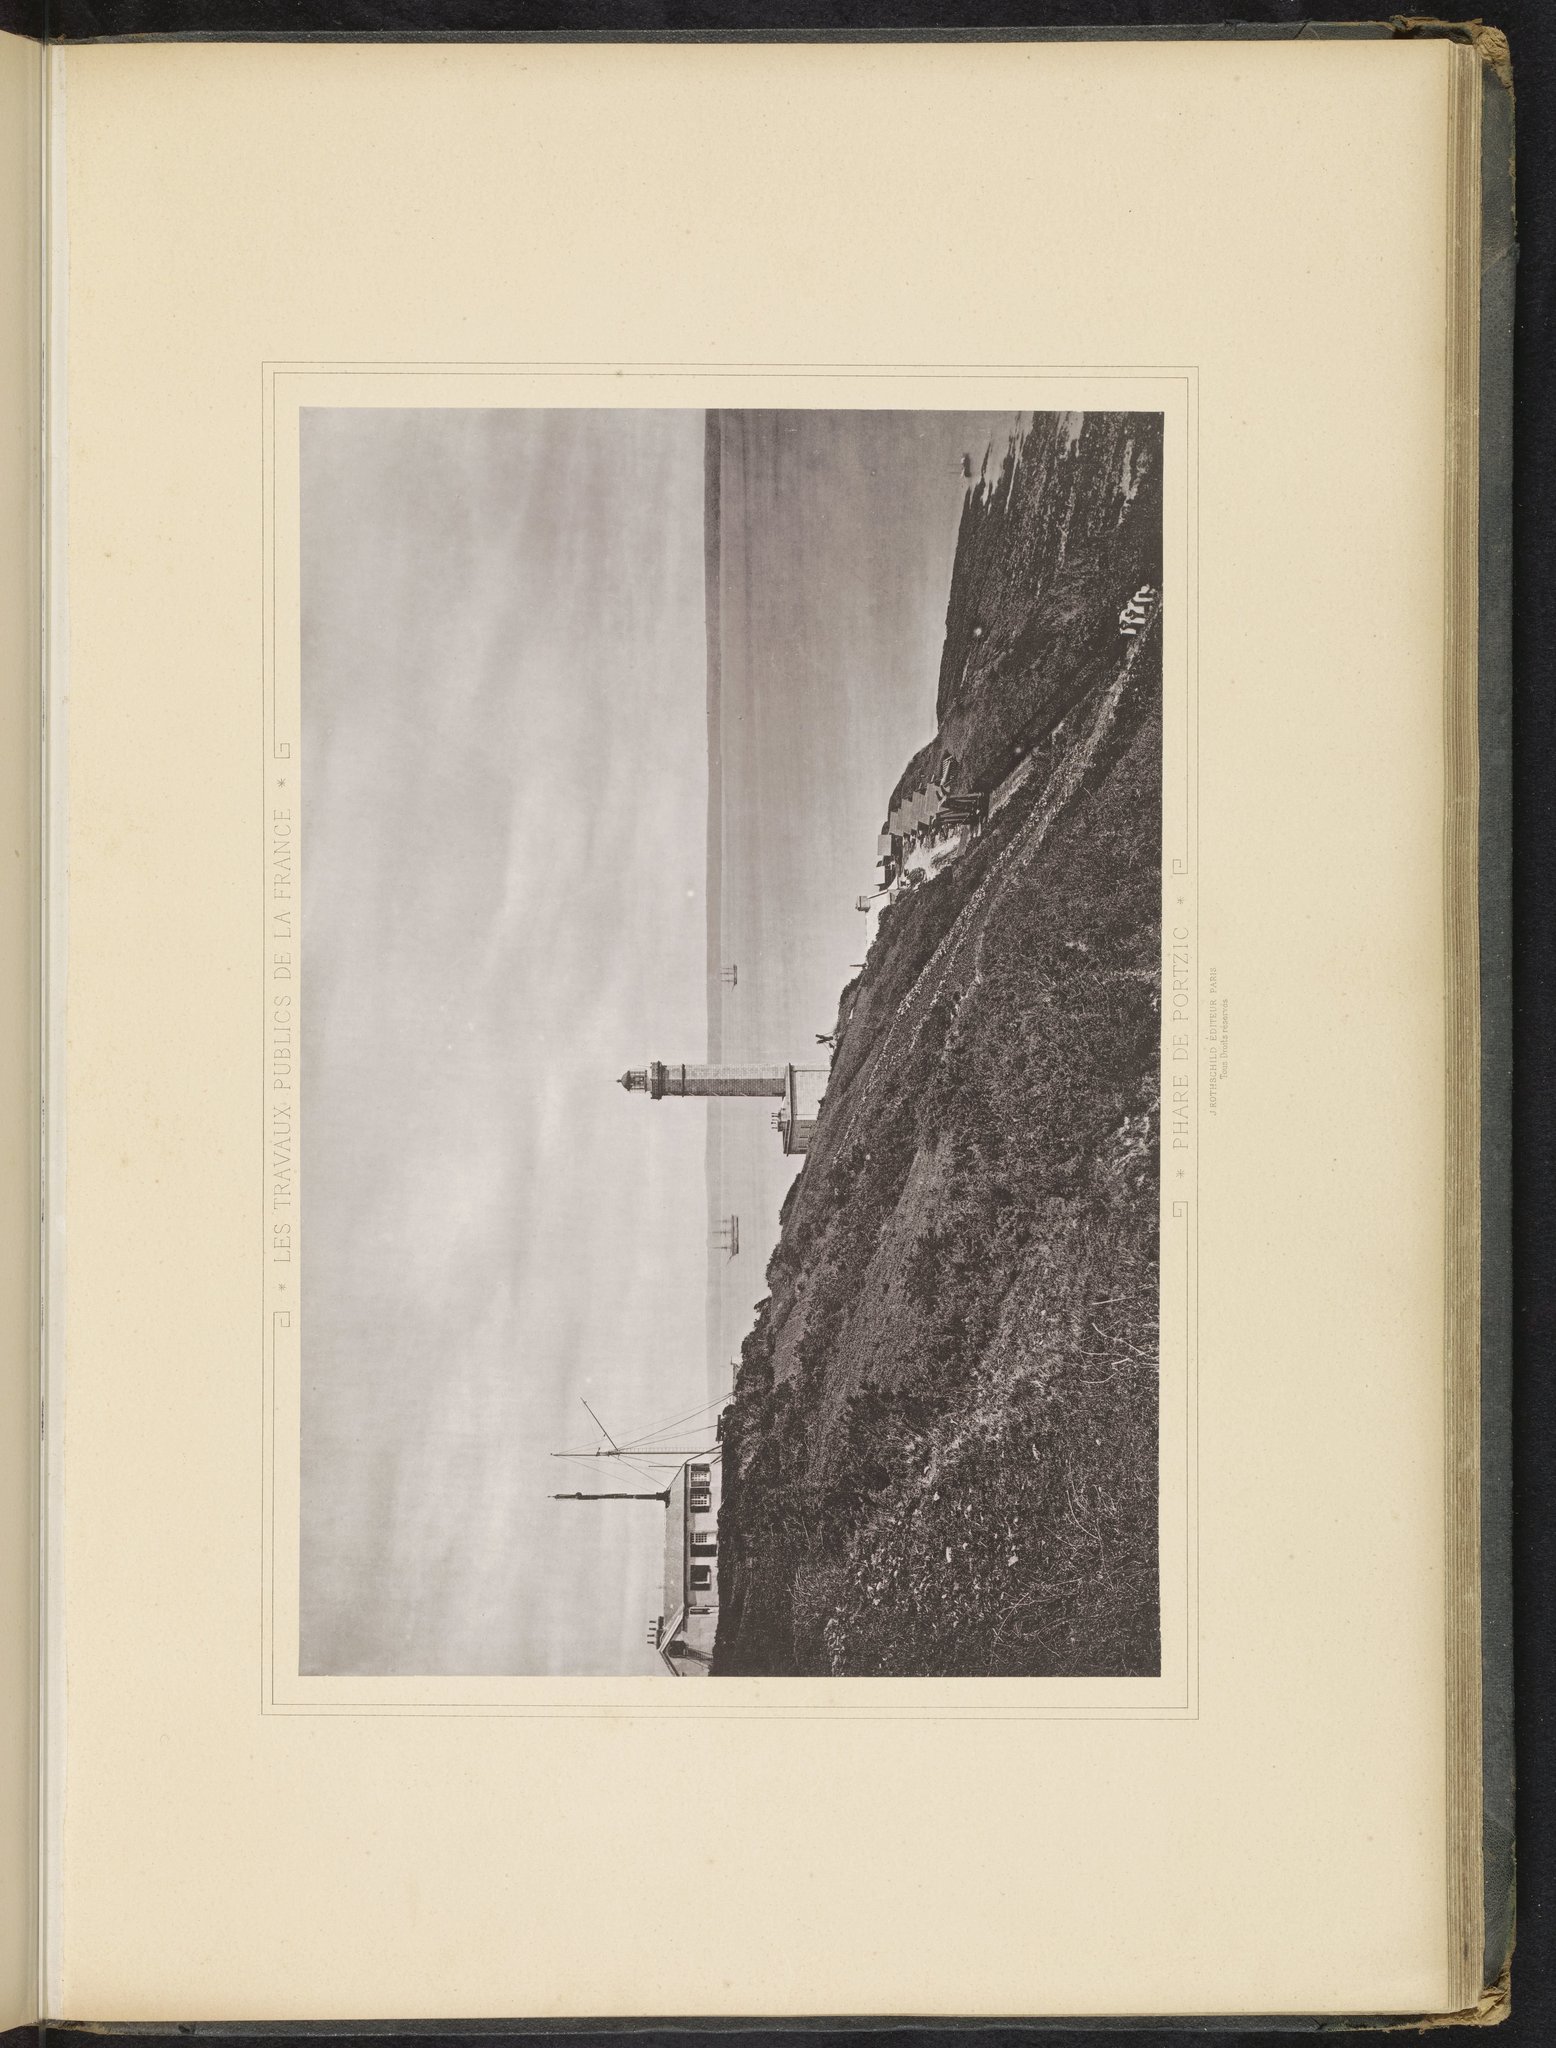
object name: photomechanical print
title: Phare de Portzic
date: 1873-1883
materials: paper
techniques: photograph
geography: france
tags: lighthouse, lightship, rocky coast